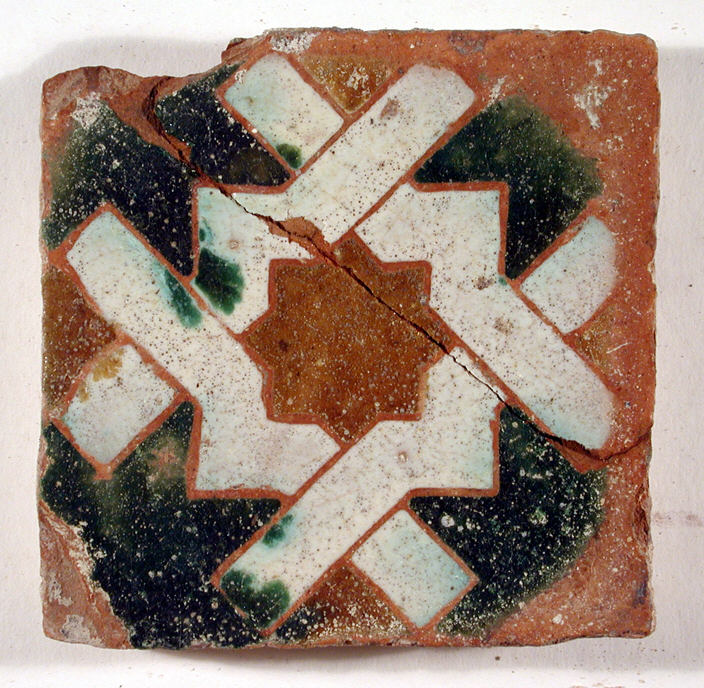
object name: pavement tile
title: Pavement tiles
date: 1501-1600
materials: earthenware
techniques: glazing